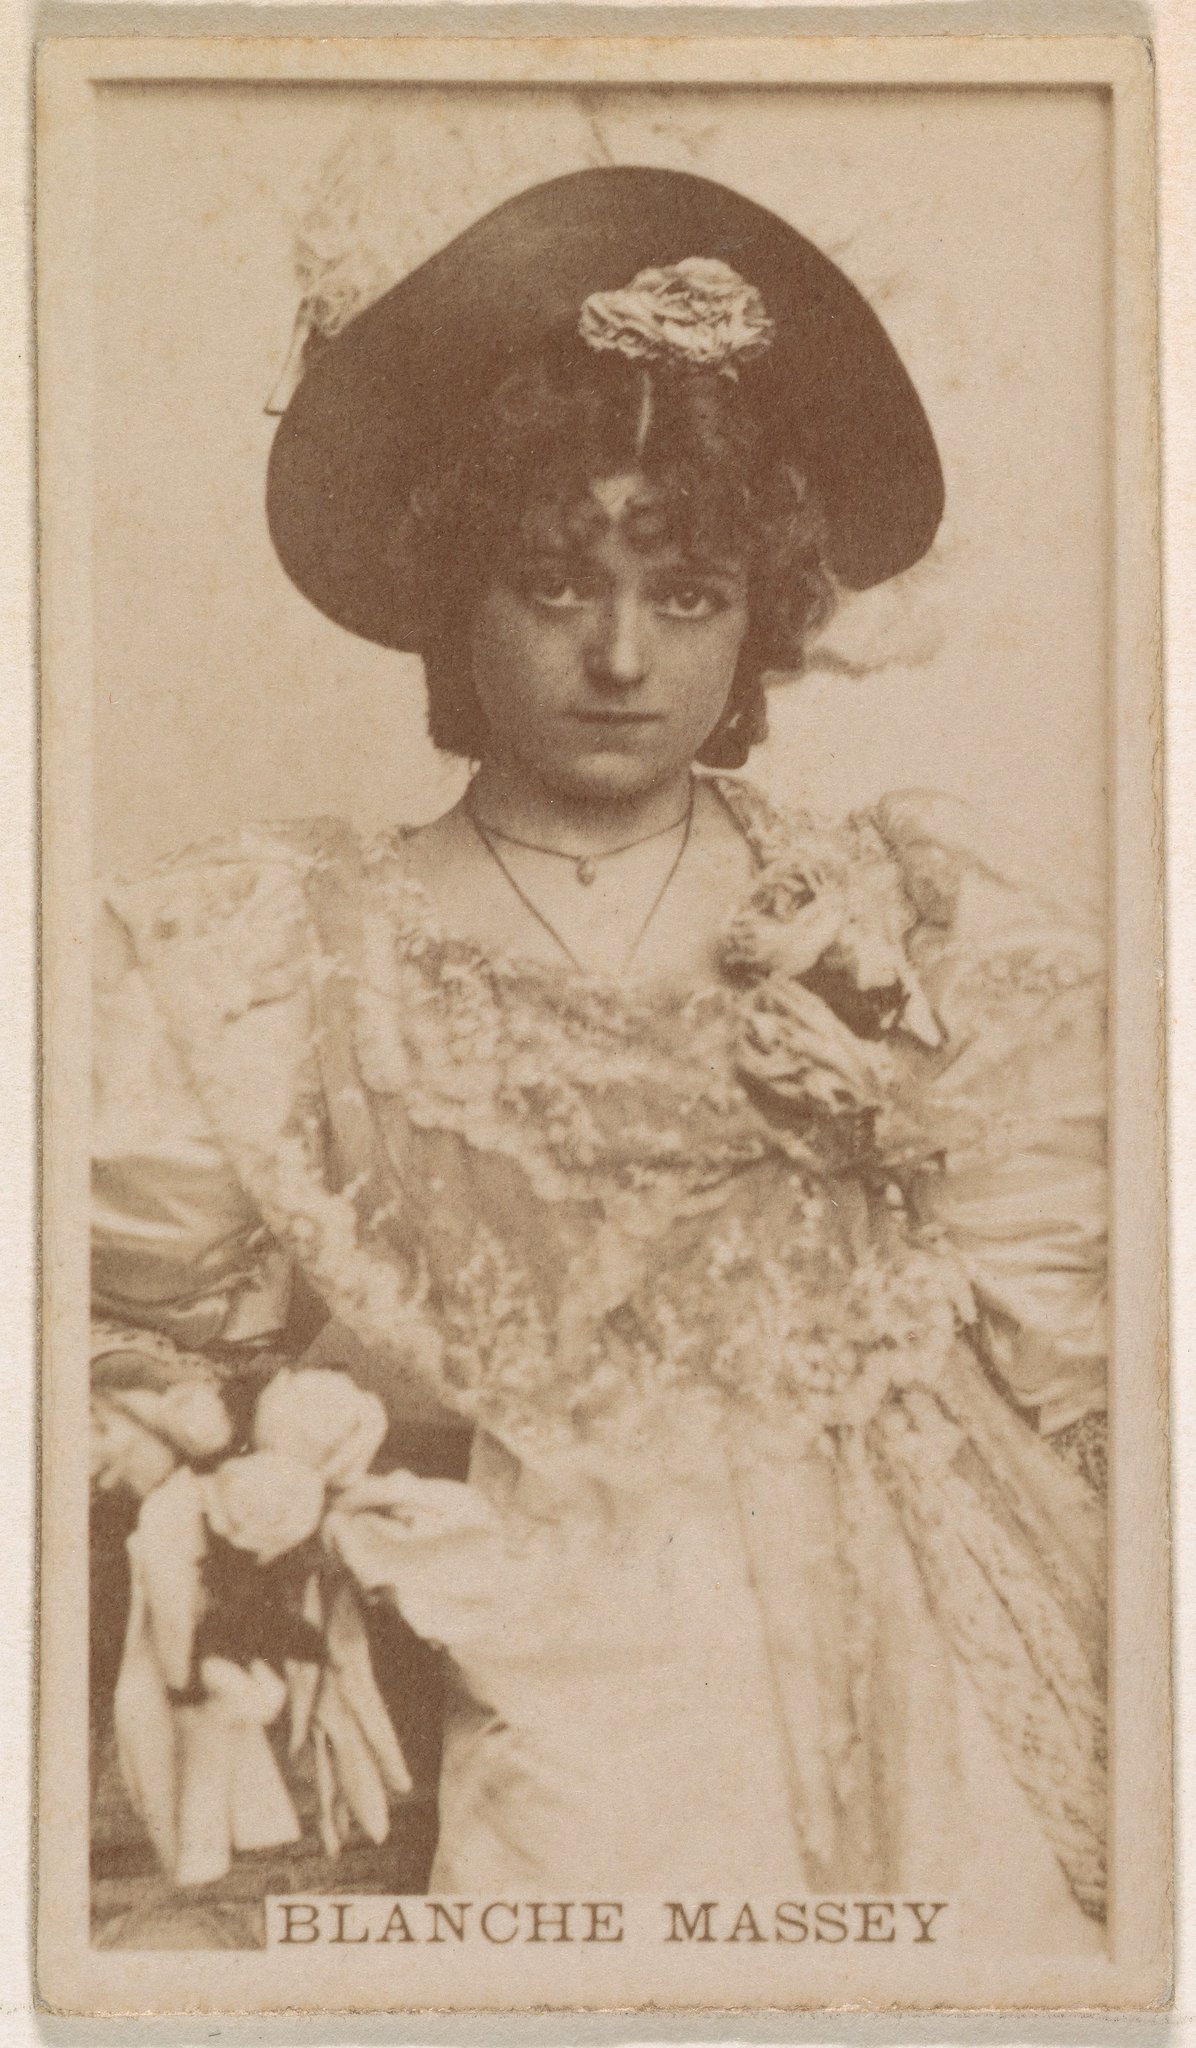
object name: photograph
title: Blanche Massey, from the Actresses series (N245) issued by Kinney Brothers to promote Sweet Caporal Cigarettes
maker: kinney brothers tobacco company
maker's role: publisher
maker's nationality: american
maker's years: 1869-2011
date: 1890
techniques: albumen silver print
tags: portraits,women,actresses